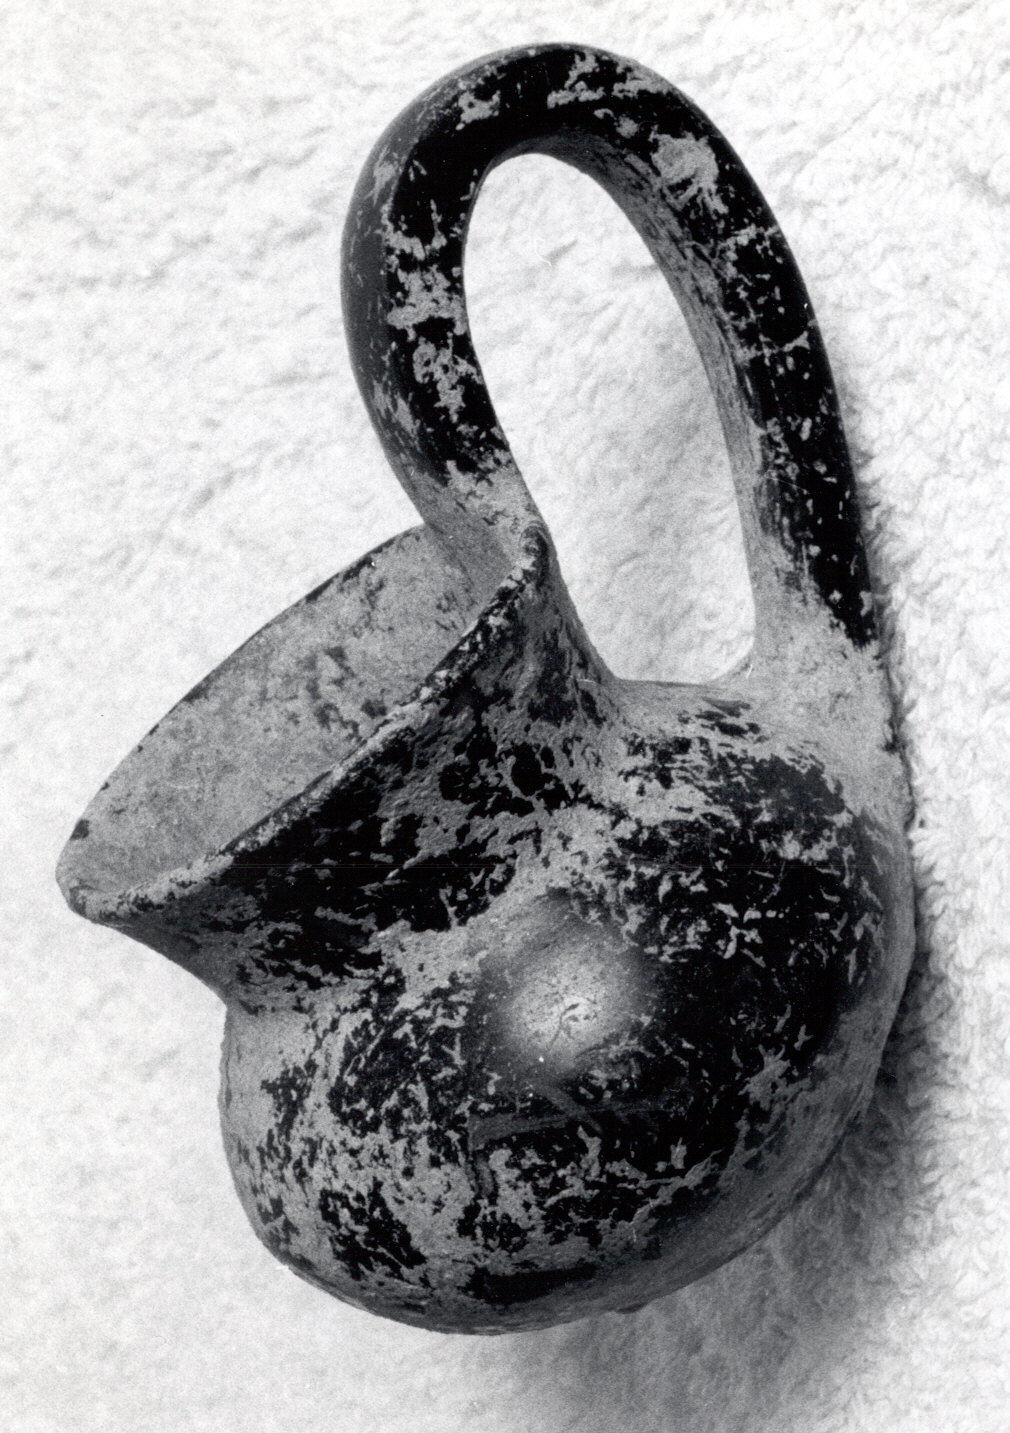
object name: vessel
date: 2333-2001 BCE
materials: ceramic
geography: anatolia